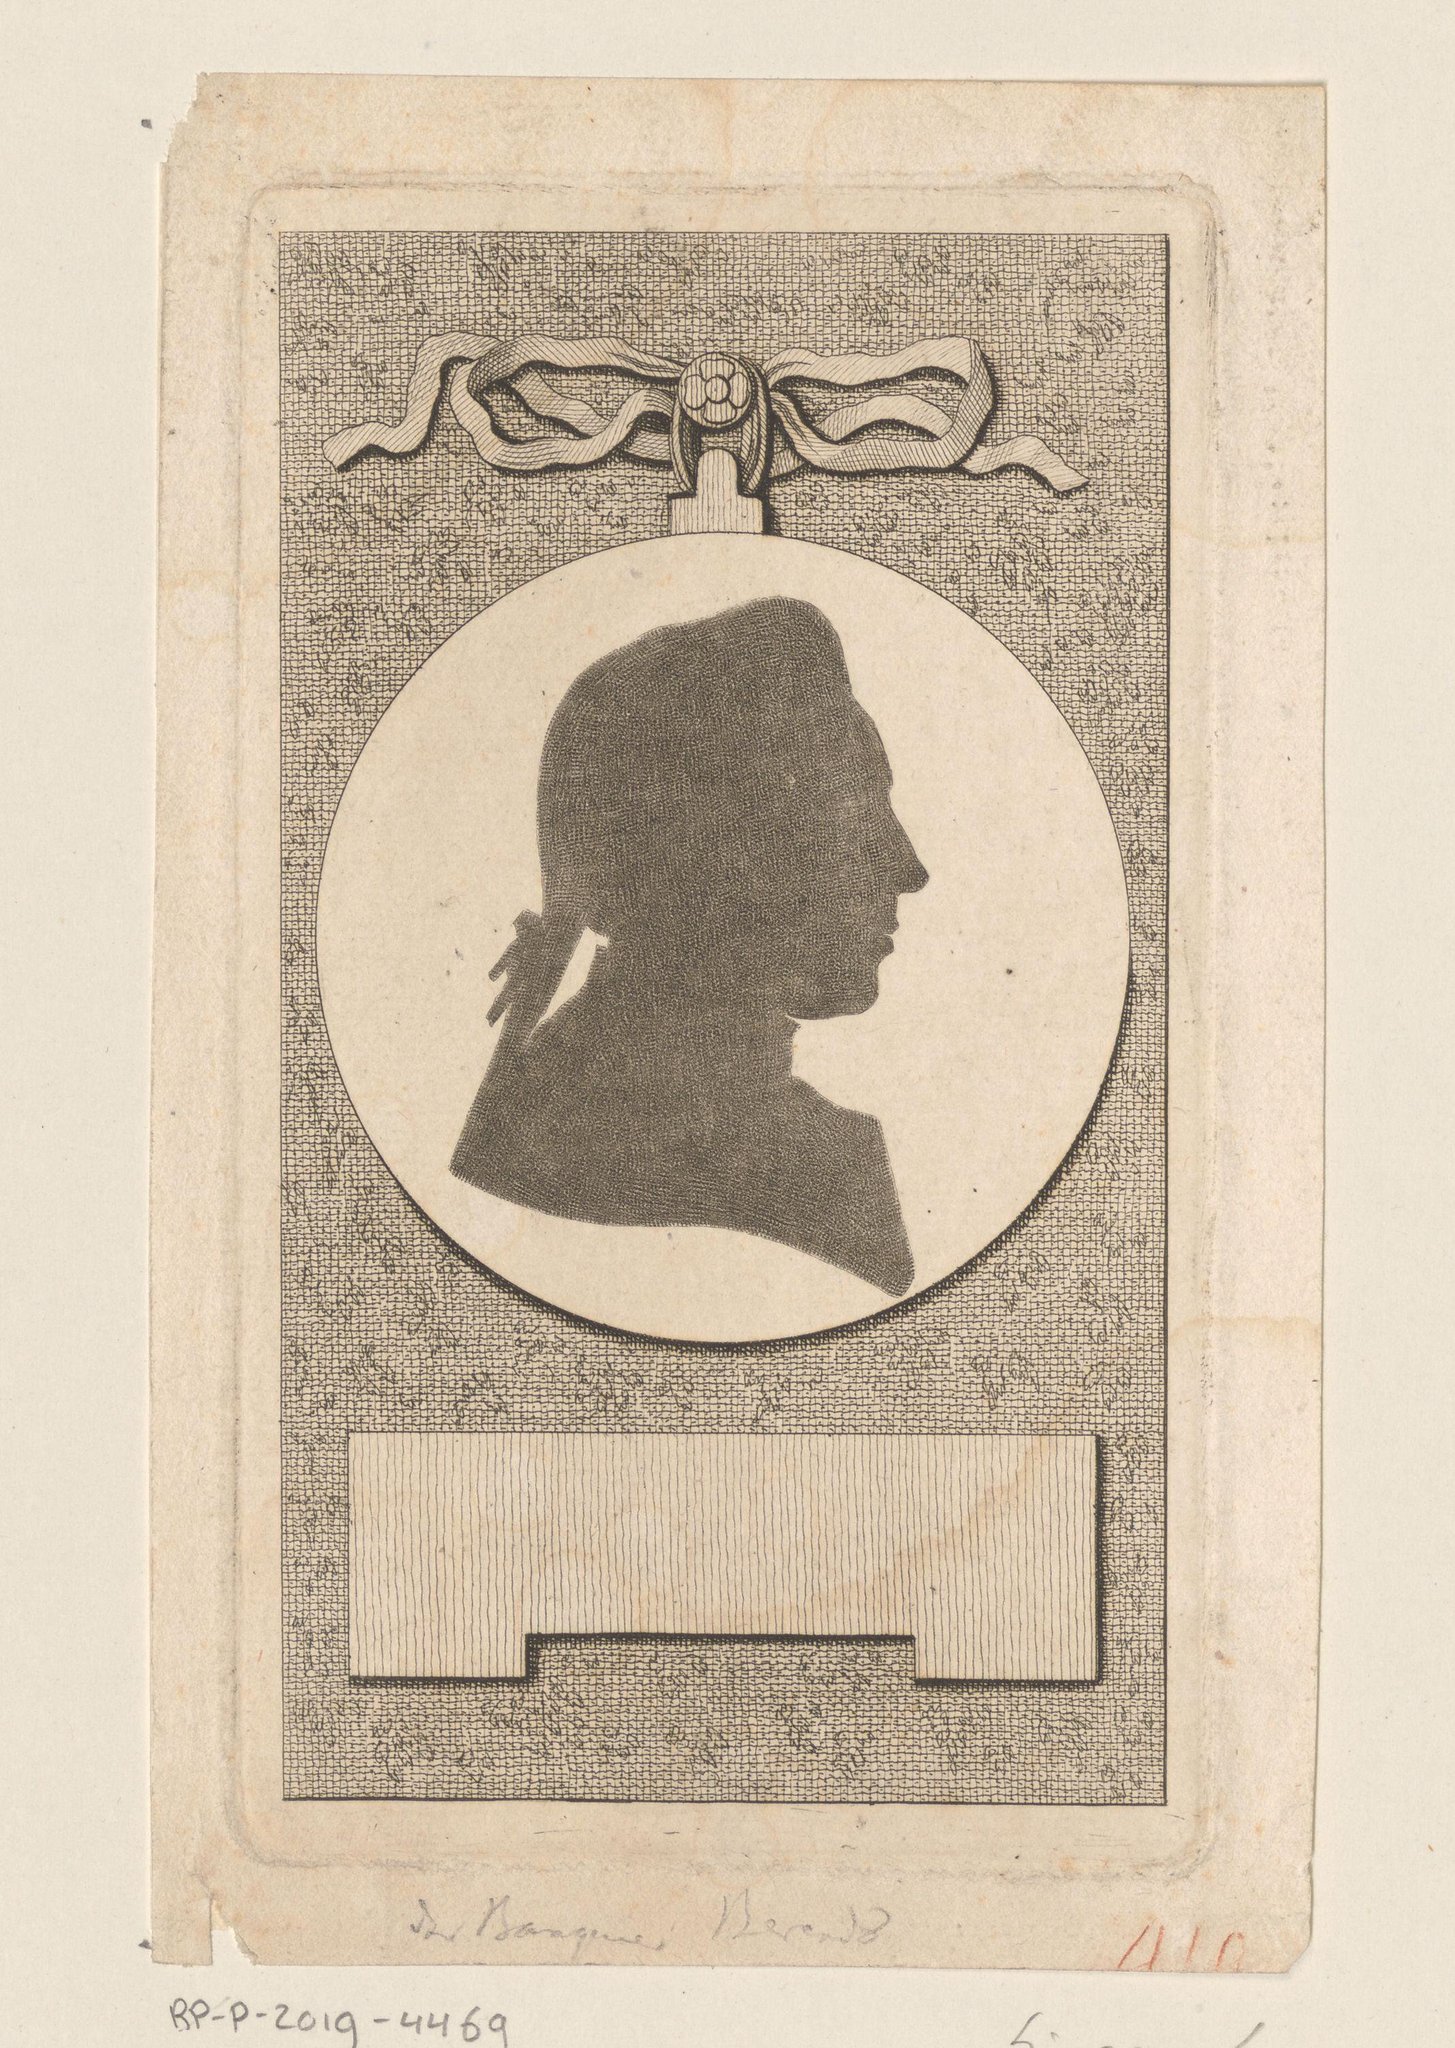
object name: print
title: Silhouetportret van een onbekende man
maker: Anonymous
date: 1775-1799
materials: paper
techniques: etching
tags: historical persons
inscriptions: collector's mark: Lugt 2228